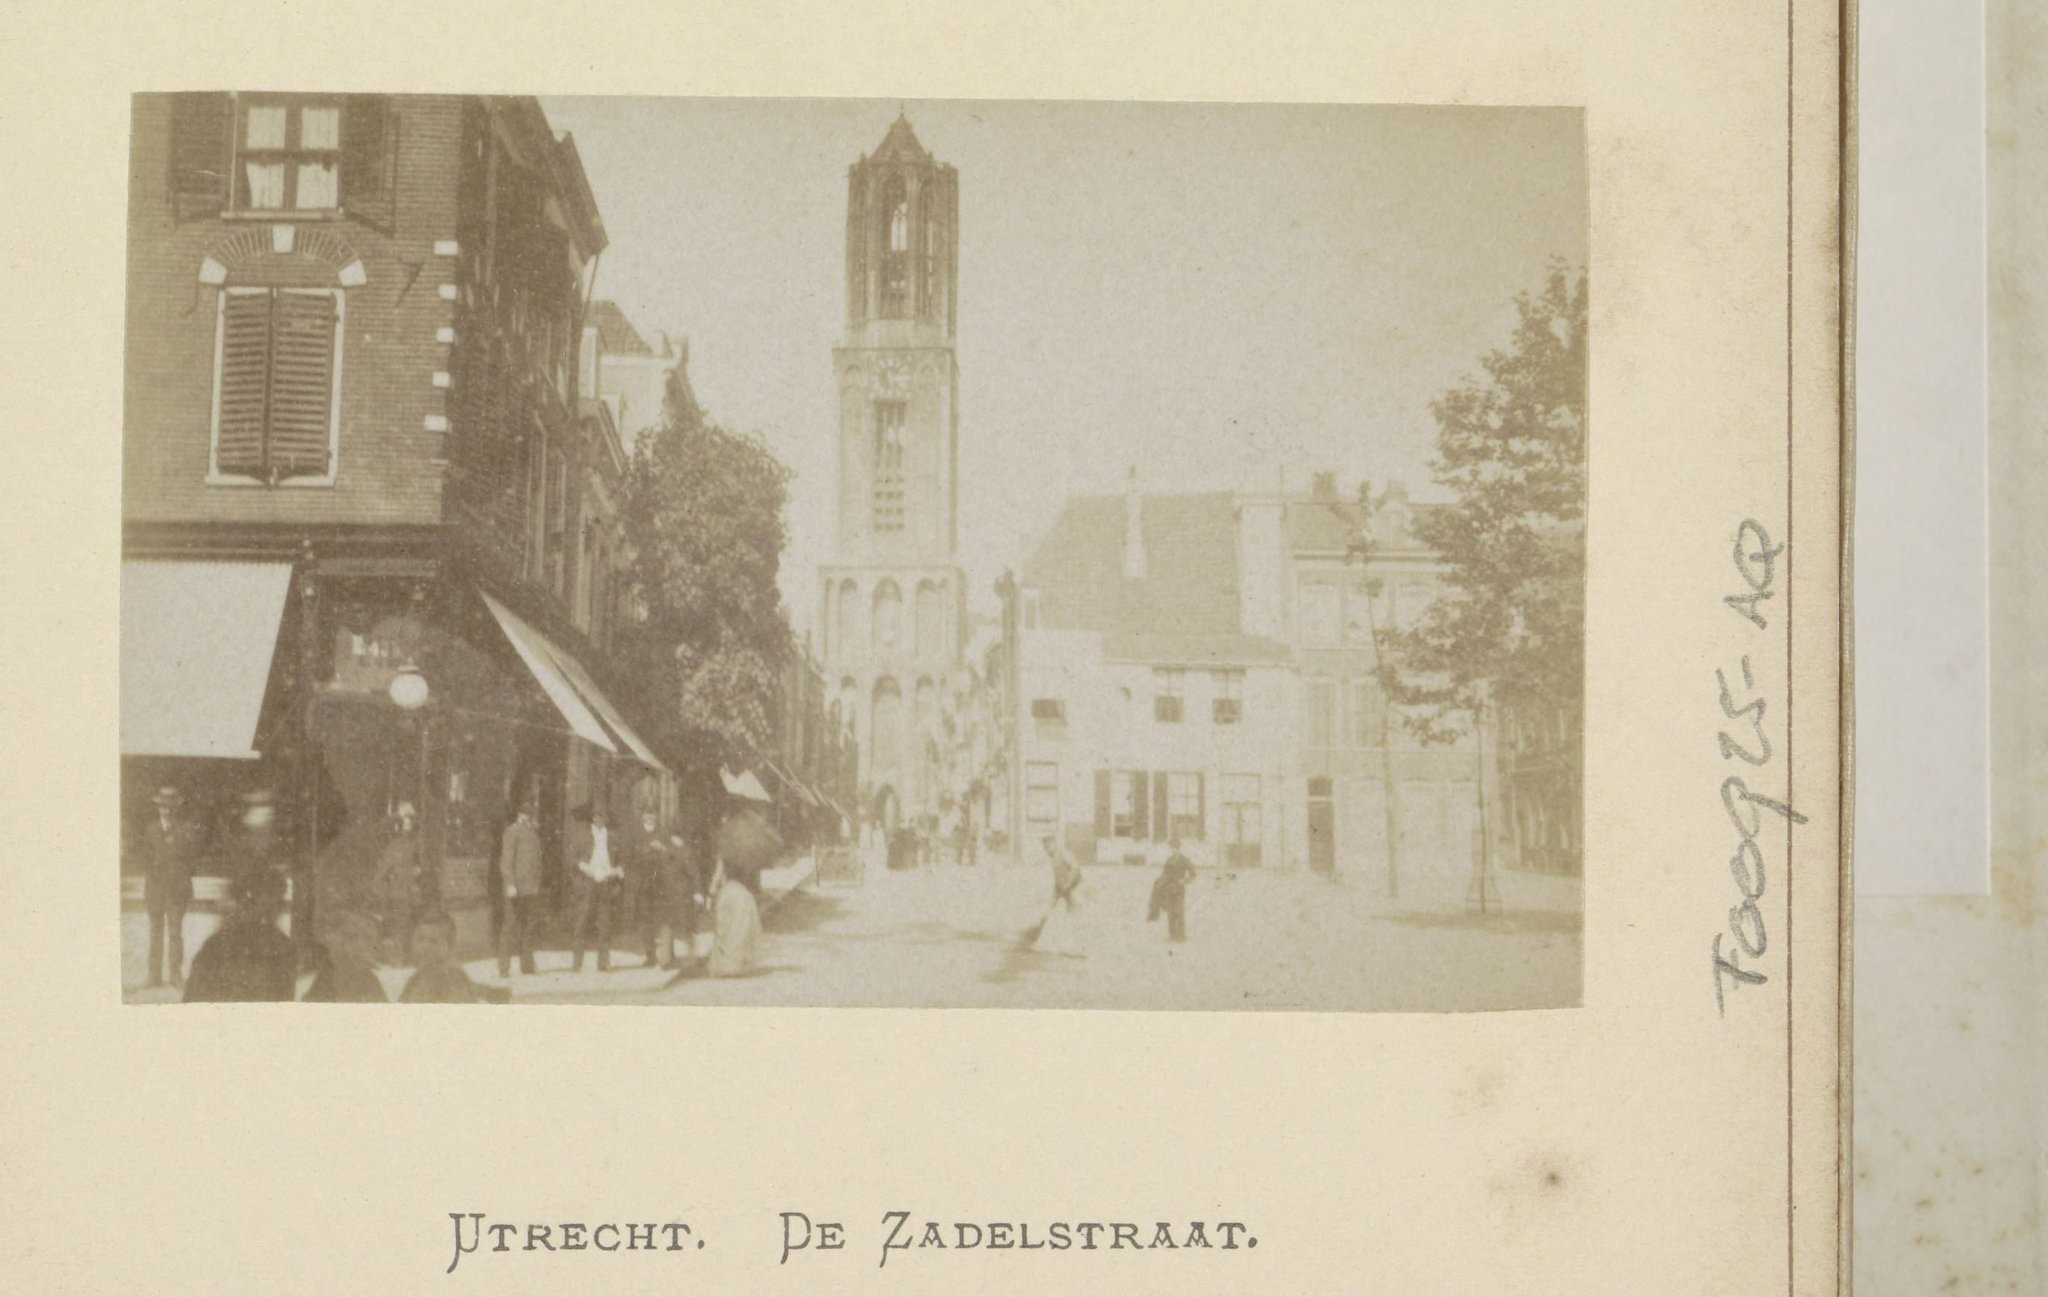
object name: album leaf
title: Utrecht. De Zadelstraat.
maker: andries jager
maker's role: publisher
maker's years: 1825-1905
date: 1860-1900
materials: cardboard, photographic support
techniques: albumen print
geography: utrecht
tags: street (+ city(-scape) with figures, staffage), parts of church exterior and annexes: tower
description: Onderdeel van Fotoalbum met opnames van steden in Noord- en Zuid-Holland en Utrecht.